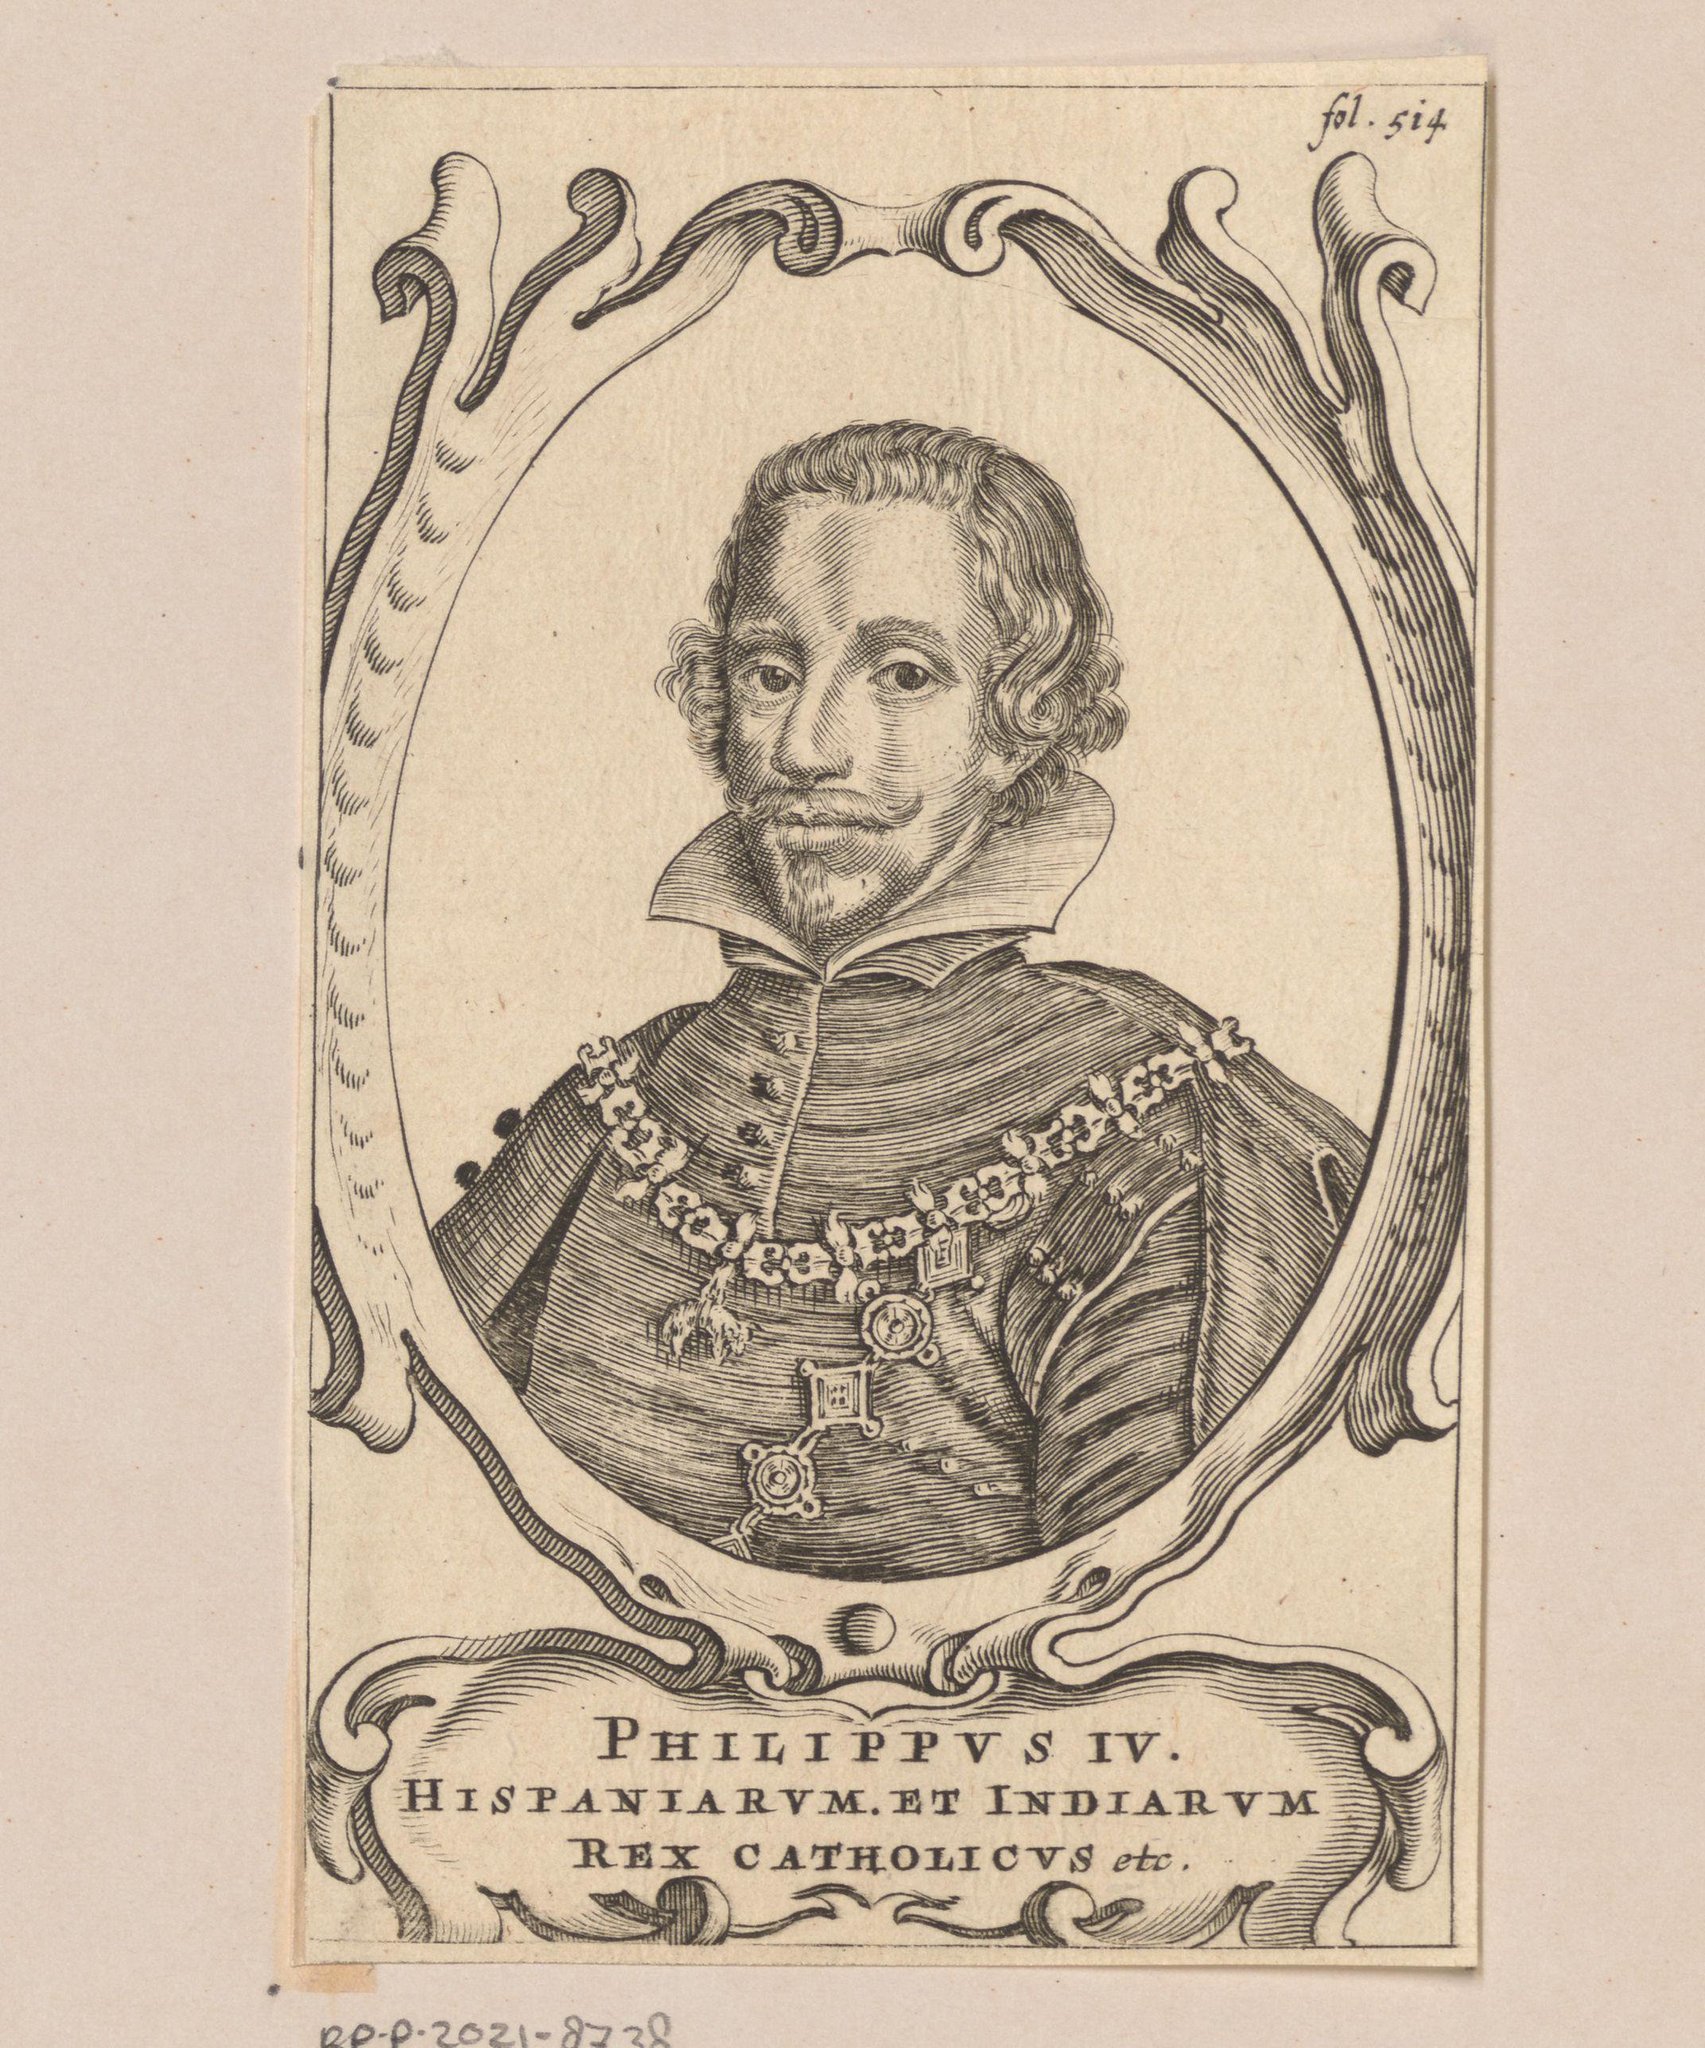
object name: print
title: Portret van Filips IV, koning van Spanje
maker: Anonymous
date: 1656-1666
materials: paper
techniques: engraving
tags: filips iv (koning van spanje), adult man, historical persons, knighthood order of the golden fleece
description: Prent waarschijnlijk uit: Brachelius, Johannes Adolphus. Historia nostri temporis, dat is geschiedenis onses tijdts (…). Rotterdam: Andries van Hoogenhuysen, 1656. Of uit de editie van 1659 of 1666.